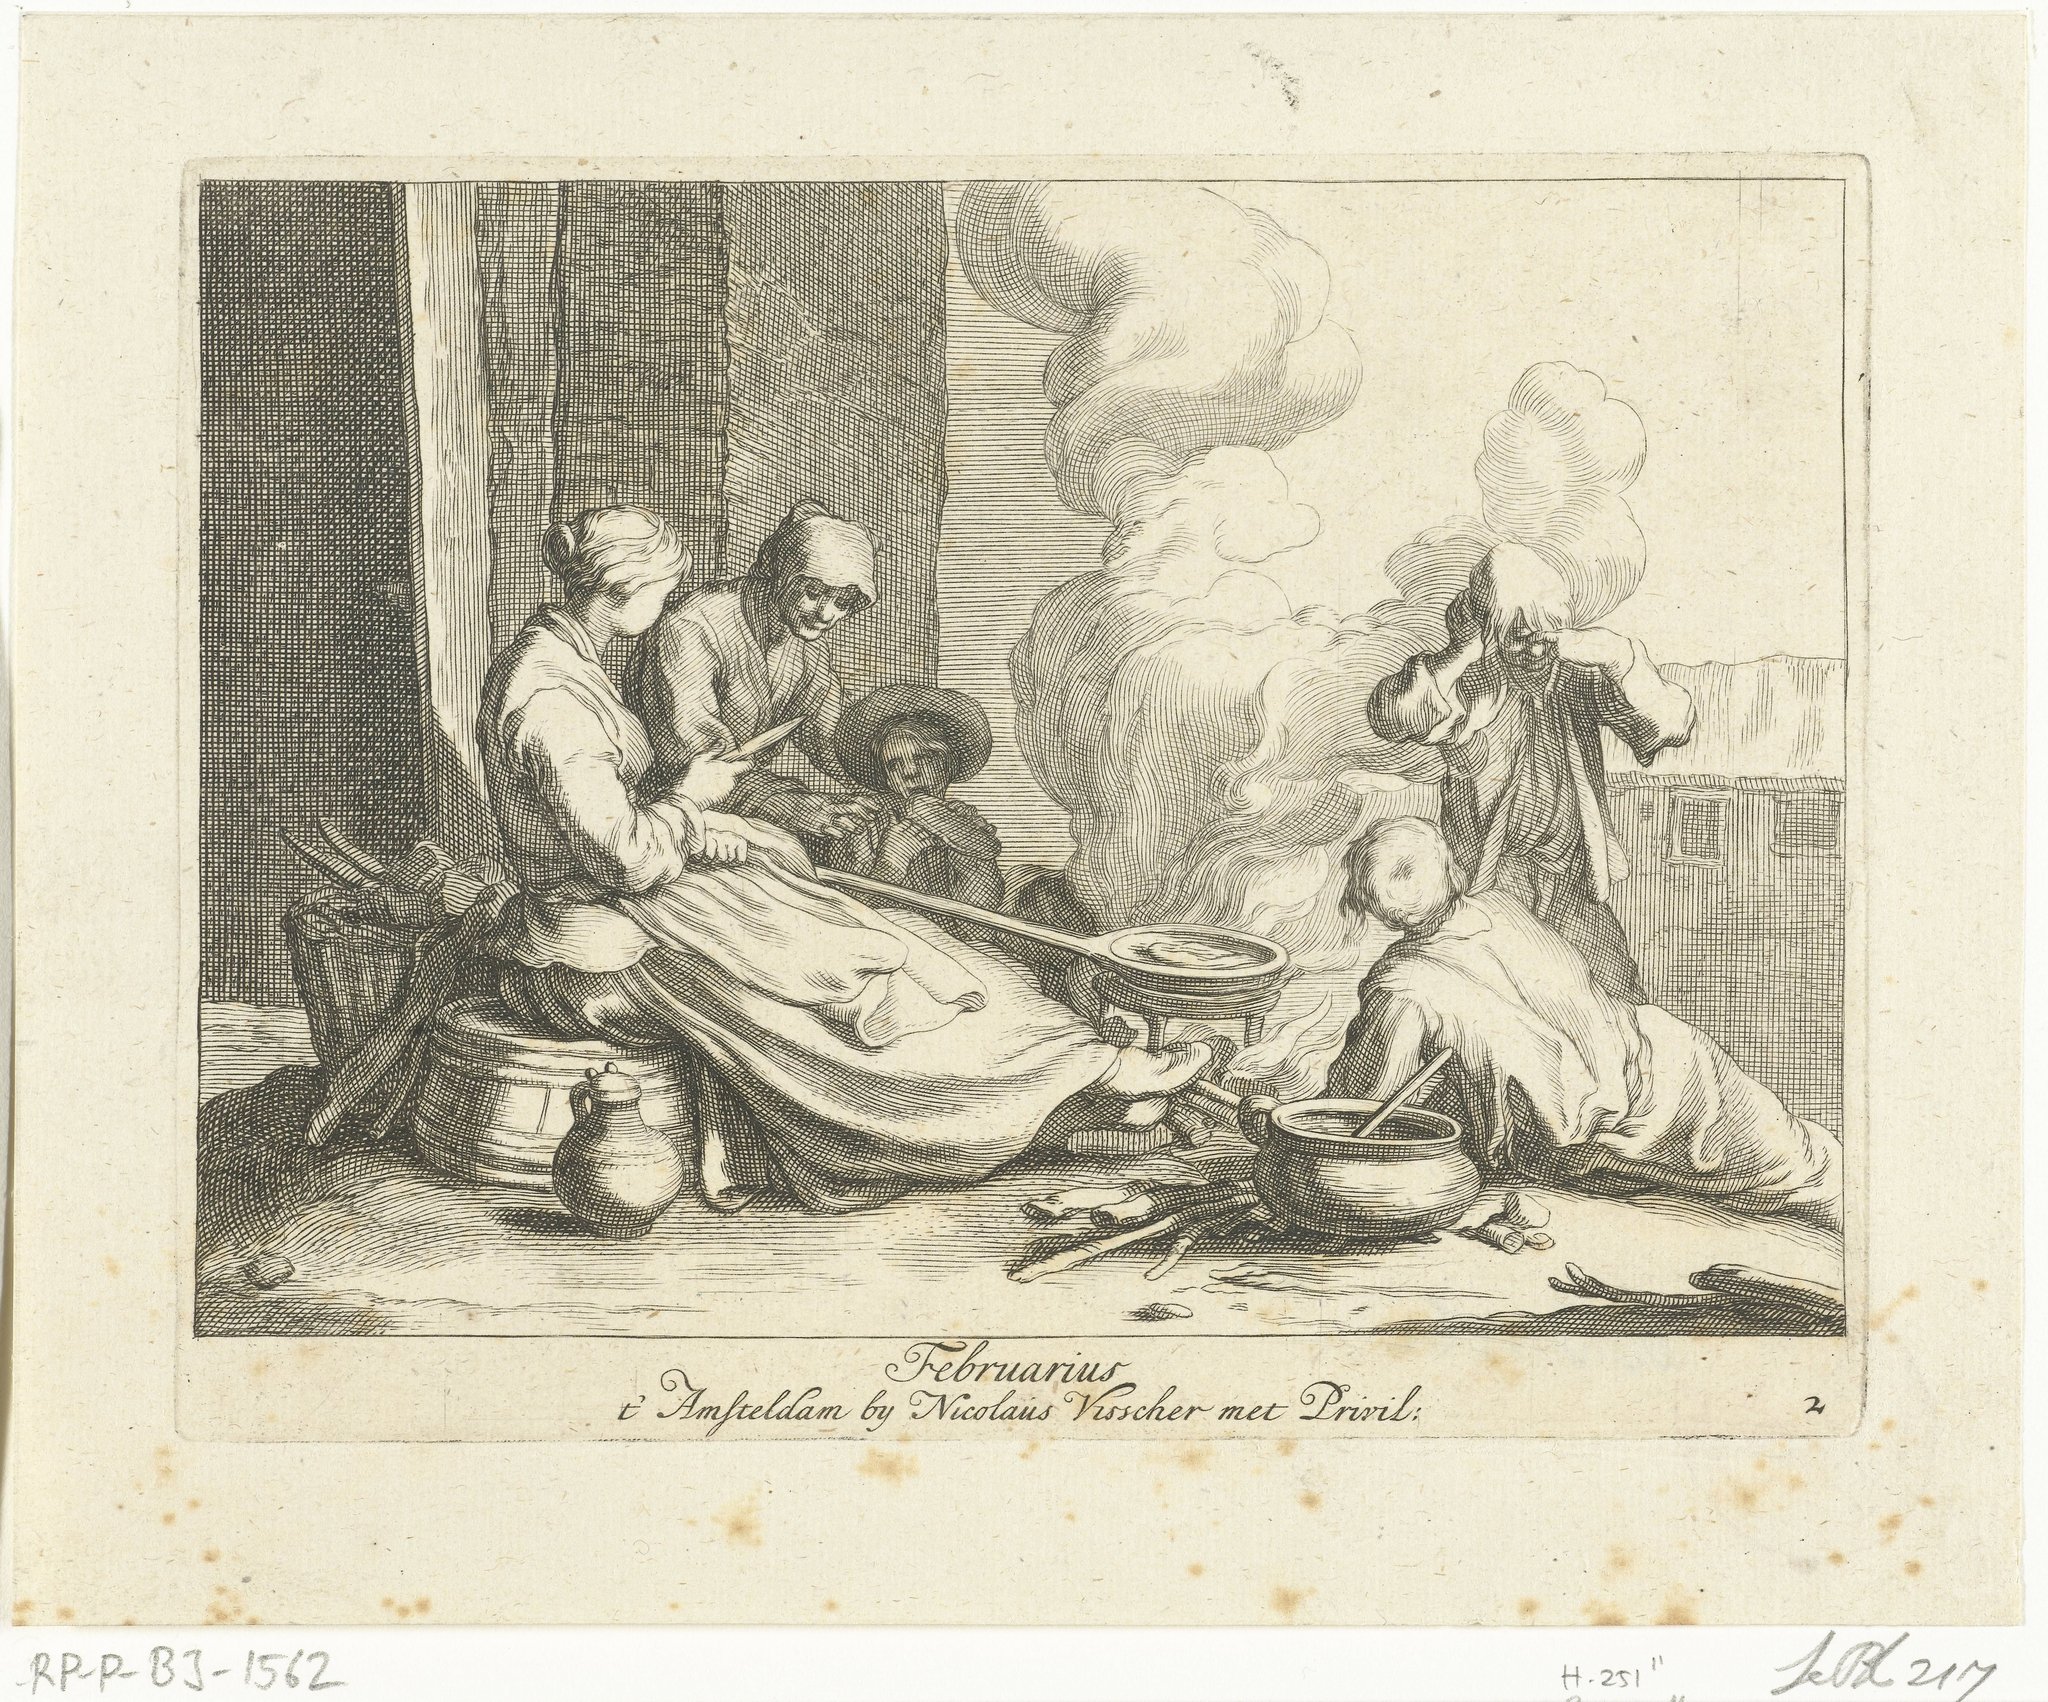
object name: print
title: Februarius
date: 1635-1670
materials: paper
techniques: engraving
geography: utrecht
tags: pancakes, february and its 'labours', frying - cc - in the open air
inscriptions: collector's mark: Lugt 240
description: Een jonge en een oude vrouwen bakken in de open lucht pannenkoeken in het bijzijn van drie kinderen.